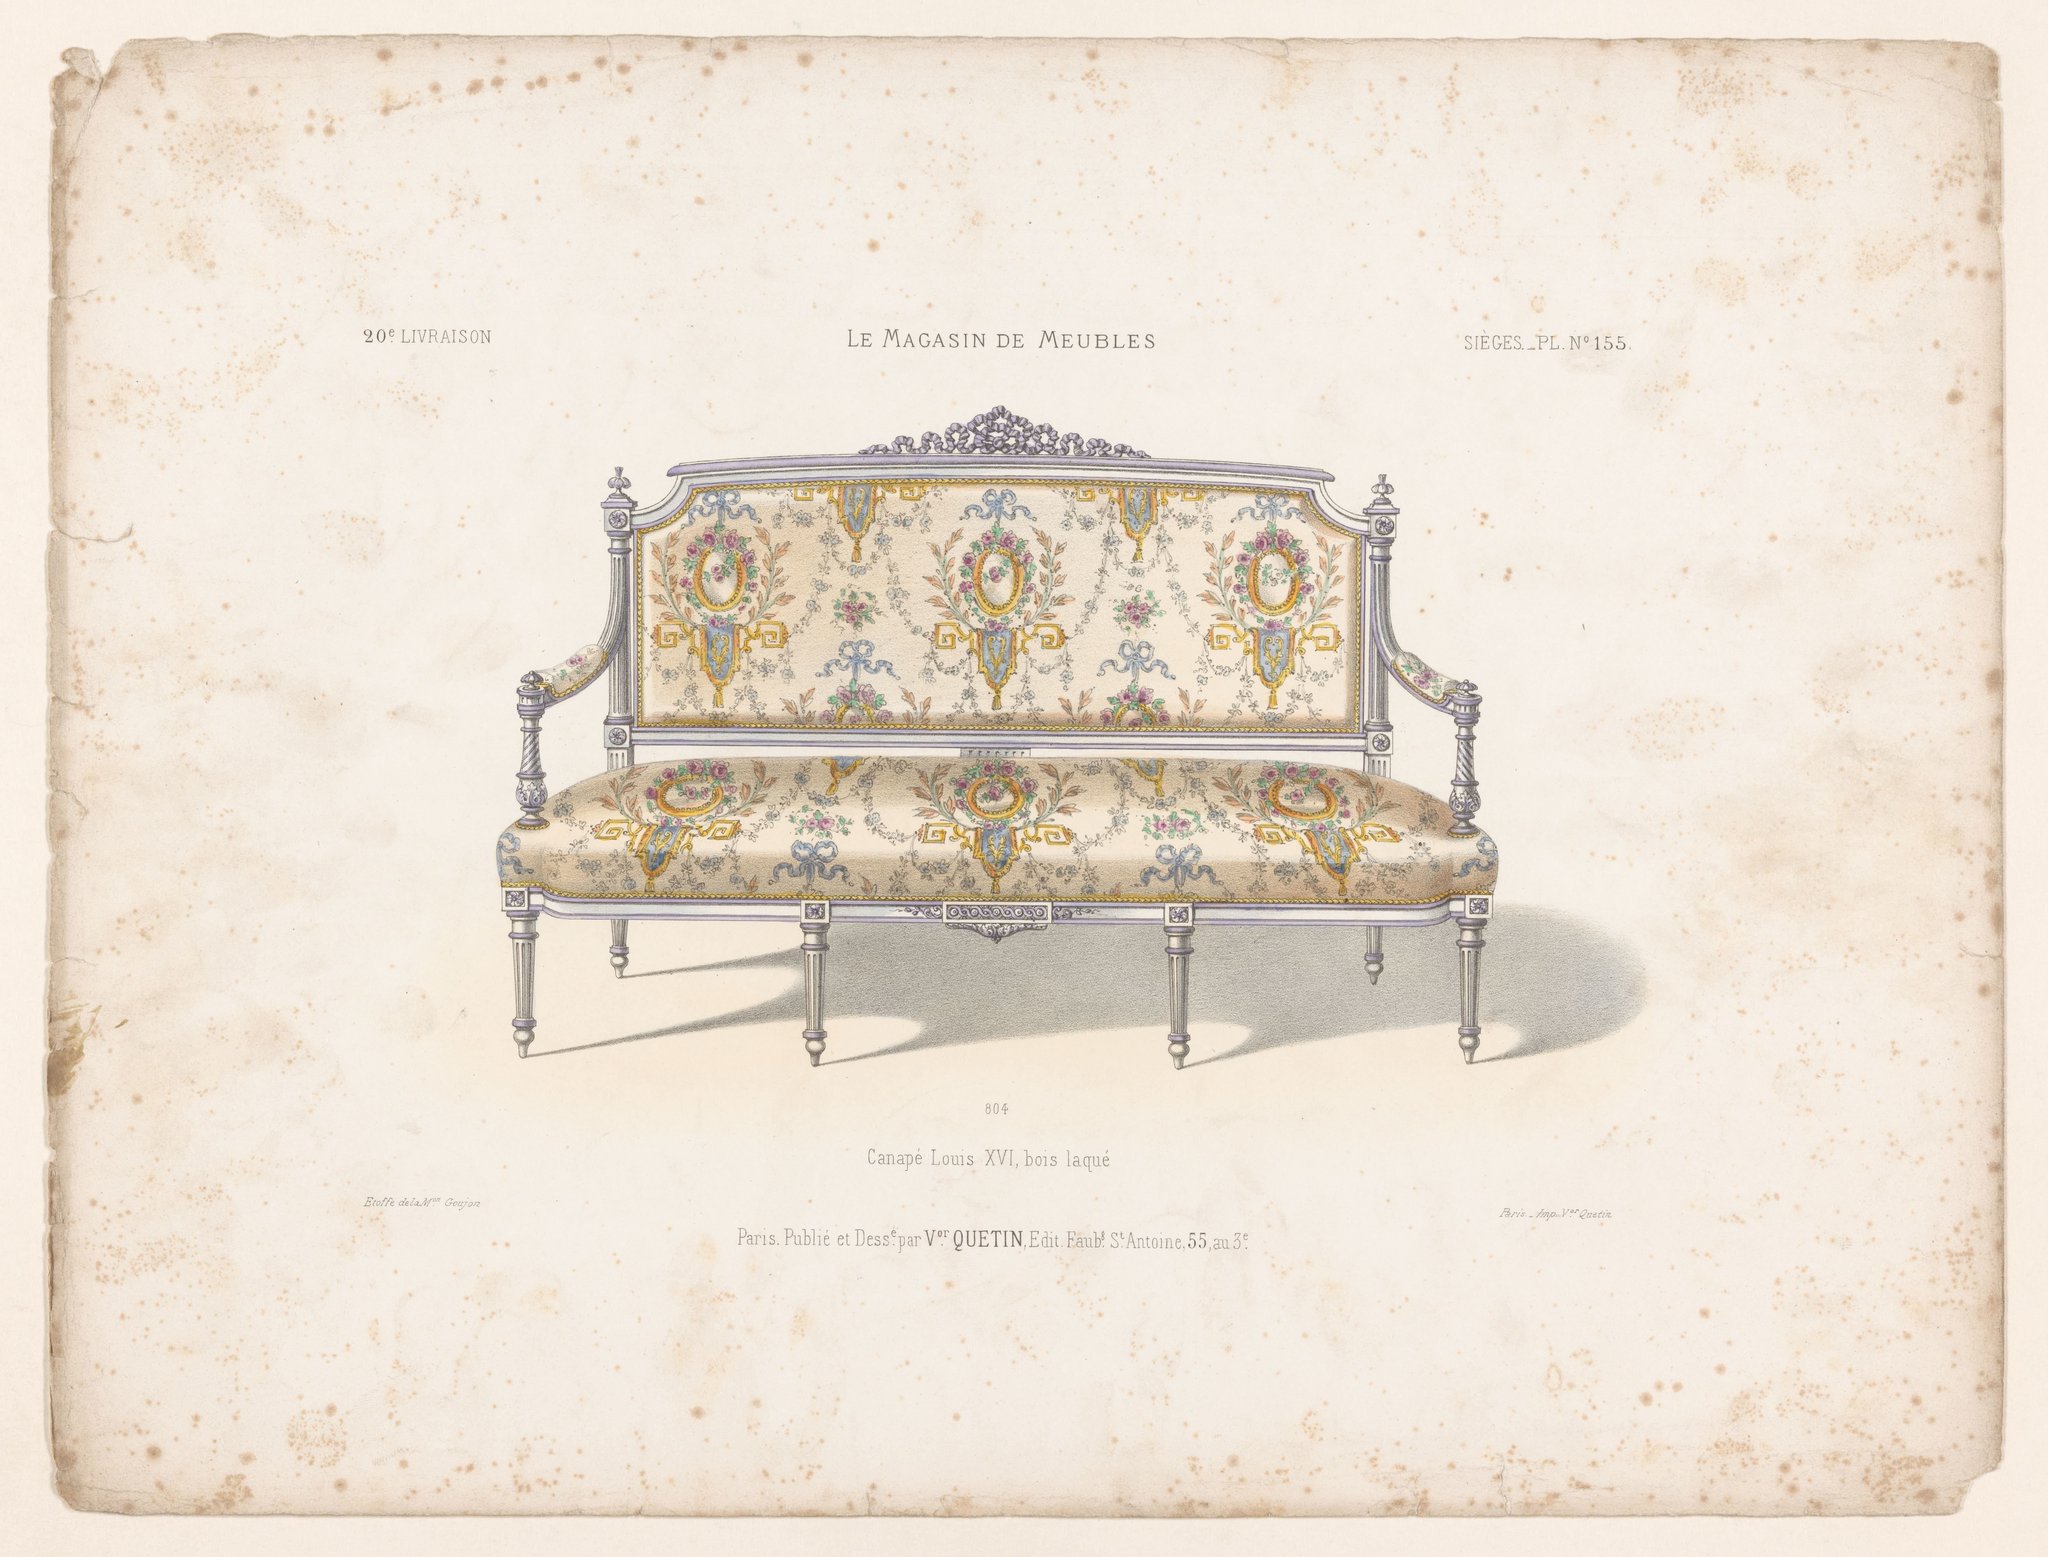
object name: print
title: Canapé Louis XVI, bois laqué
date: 1832-1877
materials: paper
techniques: hand coloring, lithograph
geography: paris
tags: seating furniture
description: Een canapé in de Lodewijk XVI-stijl. Prent uit 20e Livraison.